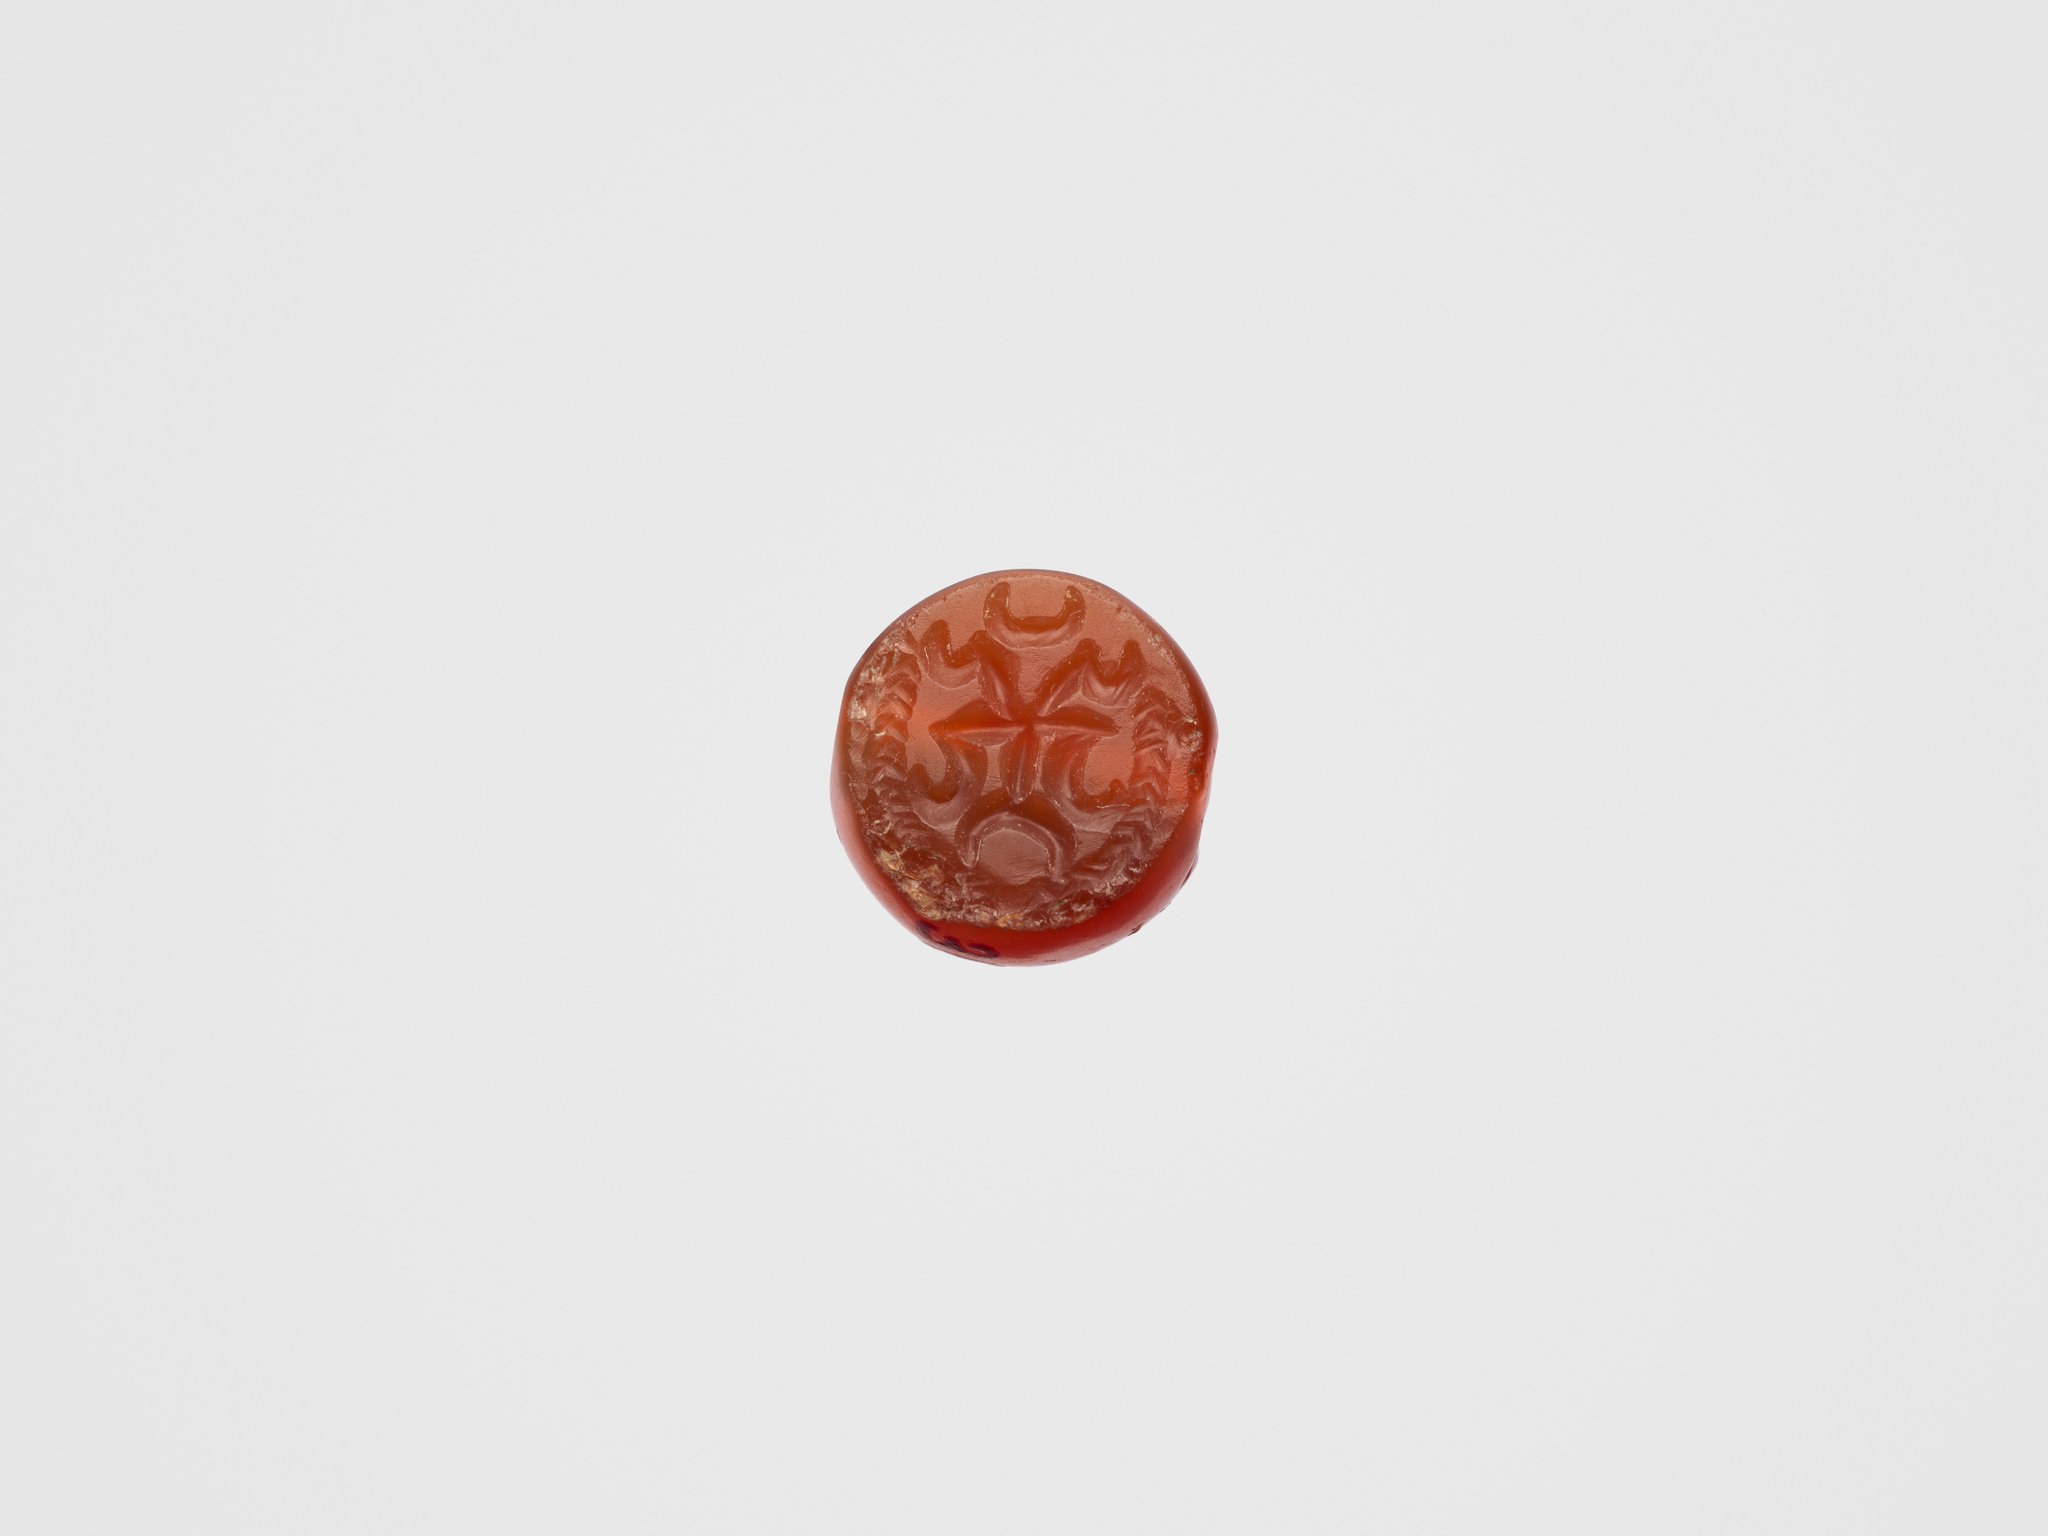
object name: stamp seal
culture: sasanian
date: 201-700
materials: gemstone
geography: iran